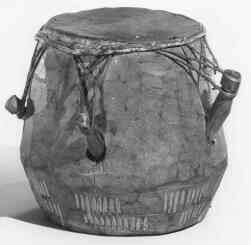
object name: drum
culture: ghanaian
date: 1801-1900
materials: wood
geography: ghana